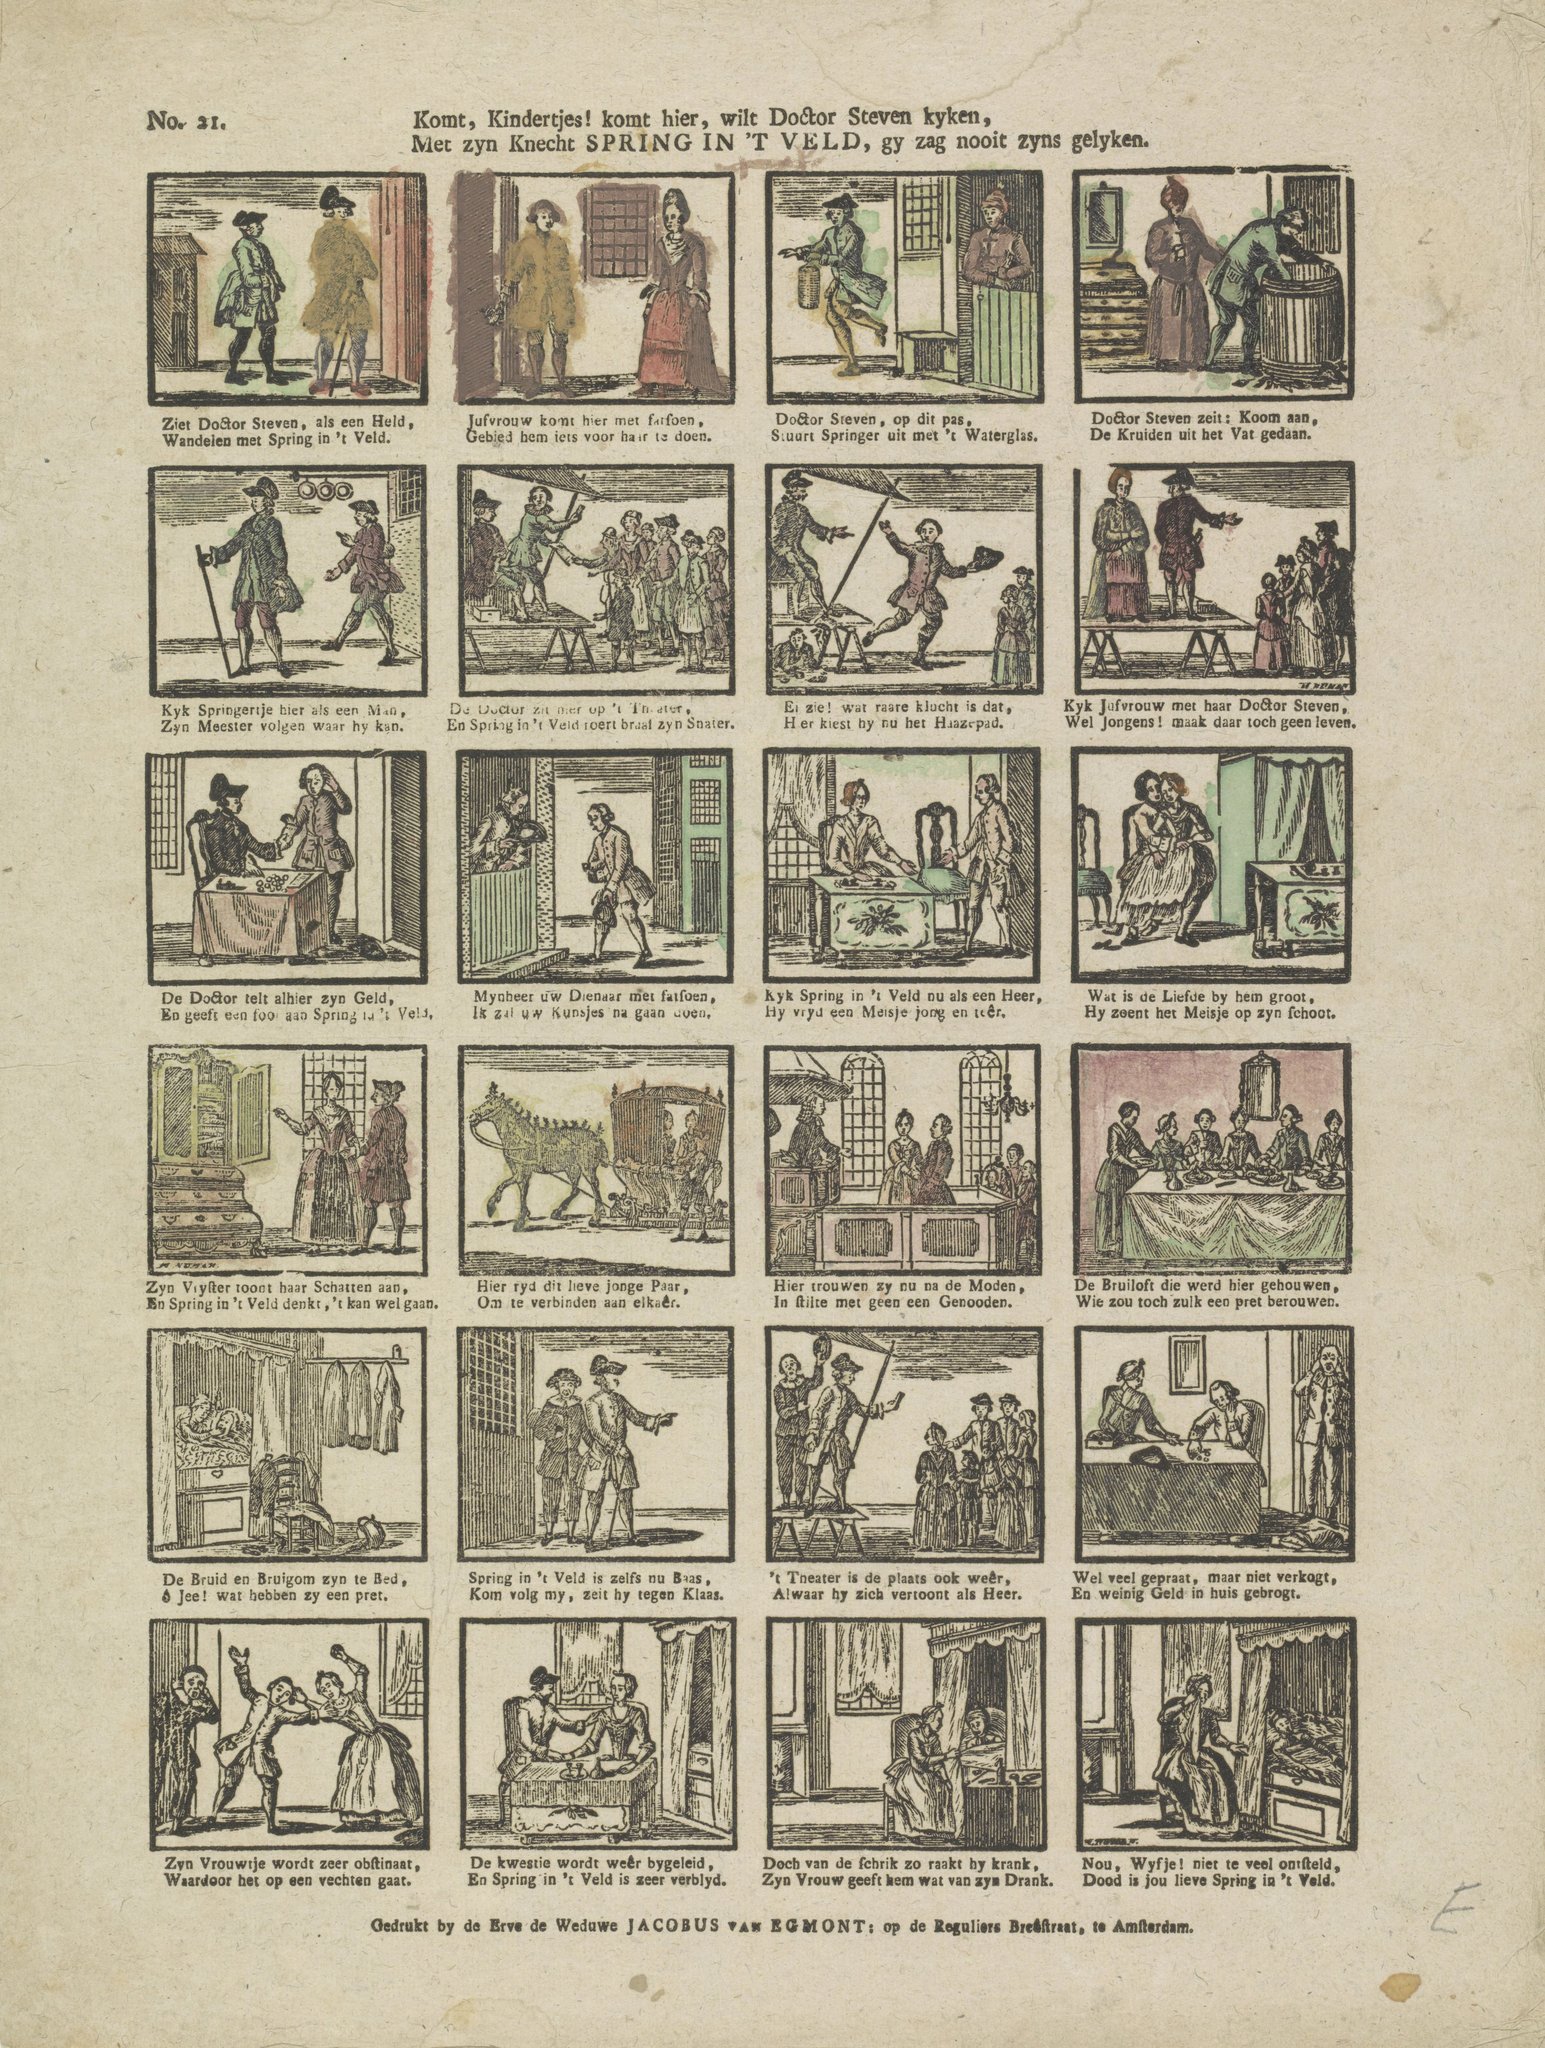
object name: popular print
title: Komt, kindertjes! komt hier, wilt doctor Steven kyken, / Met zyn knecht Sprint in 't Veld, gy zag nooit zyns gelyken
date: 1761-1804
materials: paper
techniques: colour, letterpress printing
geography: amsterdam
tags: quack, charlatan, mountebank, 'saltimbanco', man and wife quarrelling, 'marriage à la mode'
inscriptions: collector's mark: Lugt 2228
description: Blad met 24 voorstellingen over het leven van de kwakzalver dr. Steeven en zijn knecht Spring in 't Veld. Onder elke afbeelding een tweeregelig vers. Genummerd linksboven: No. 21.